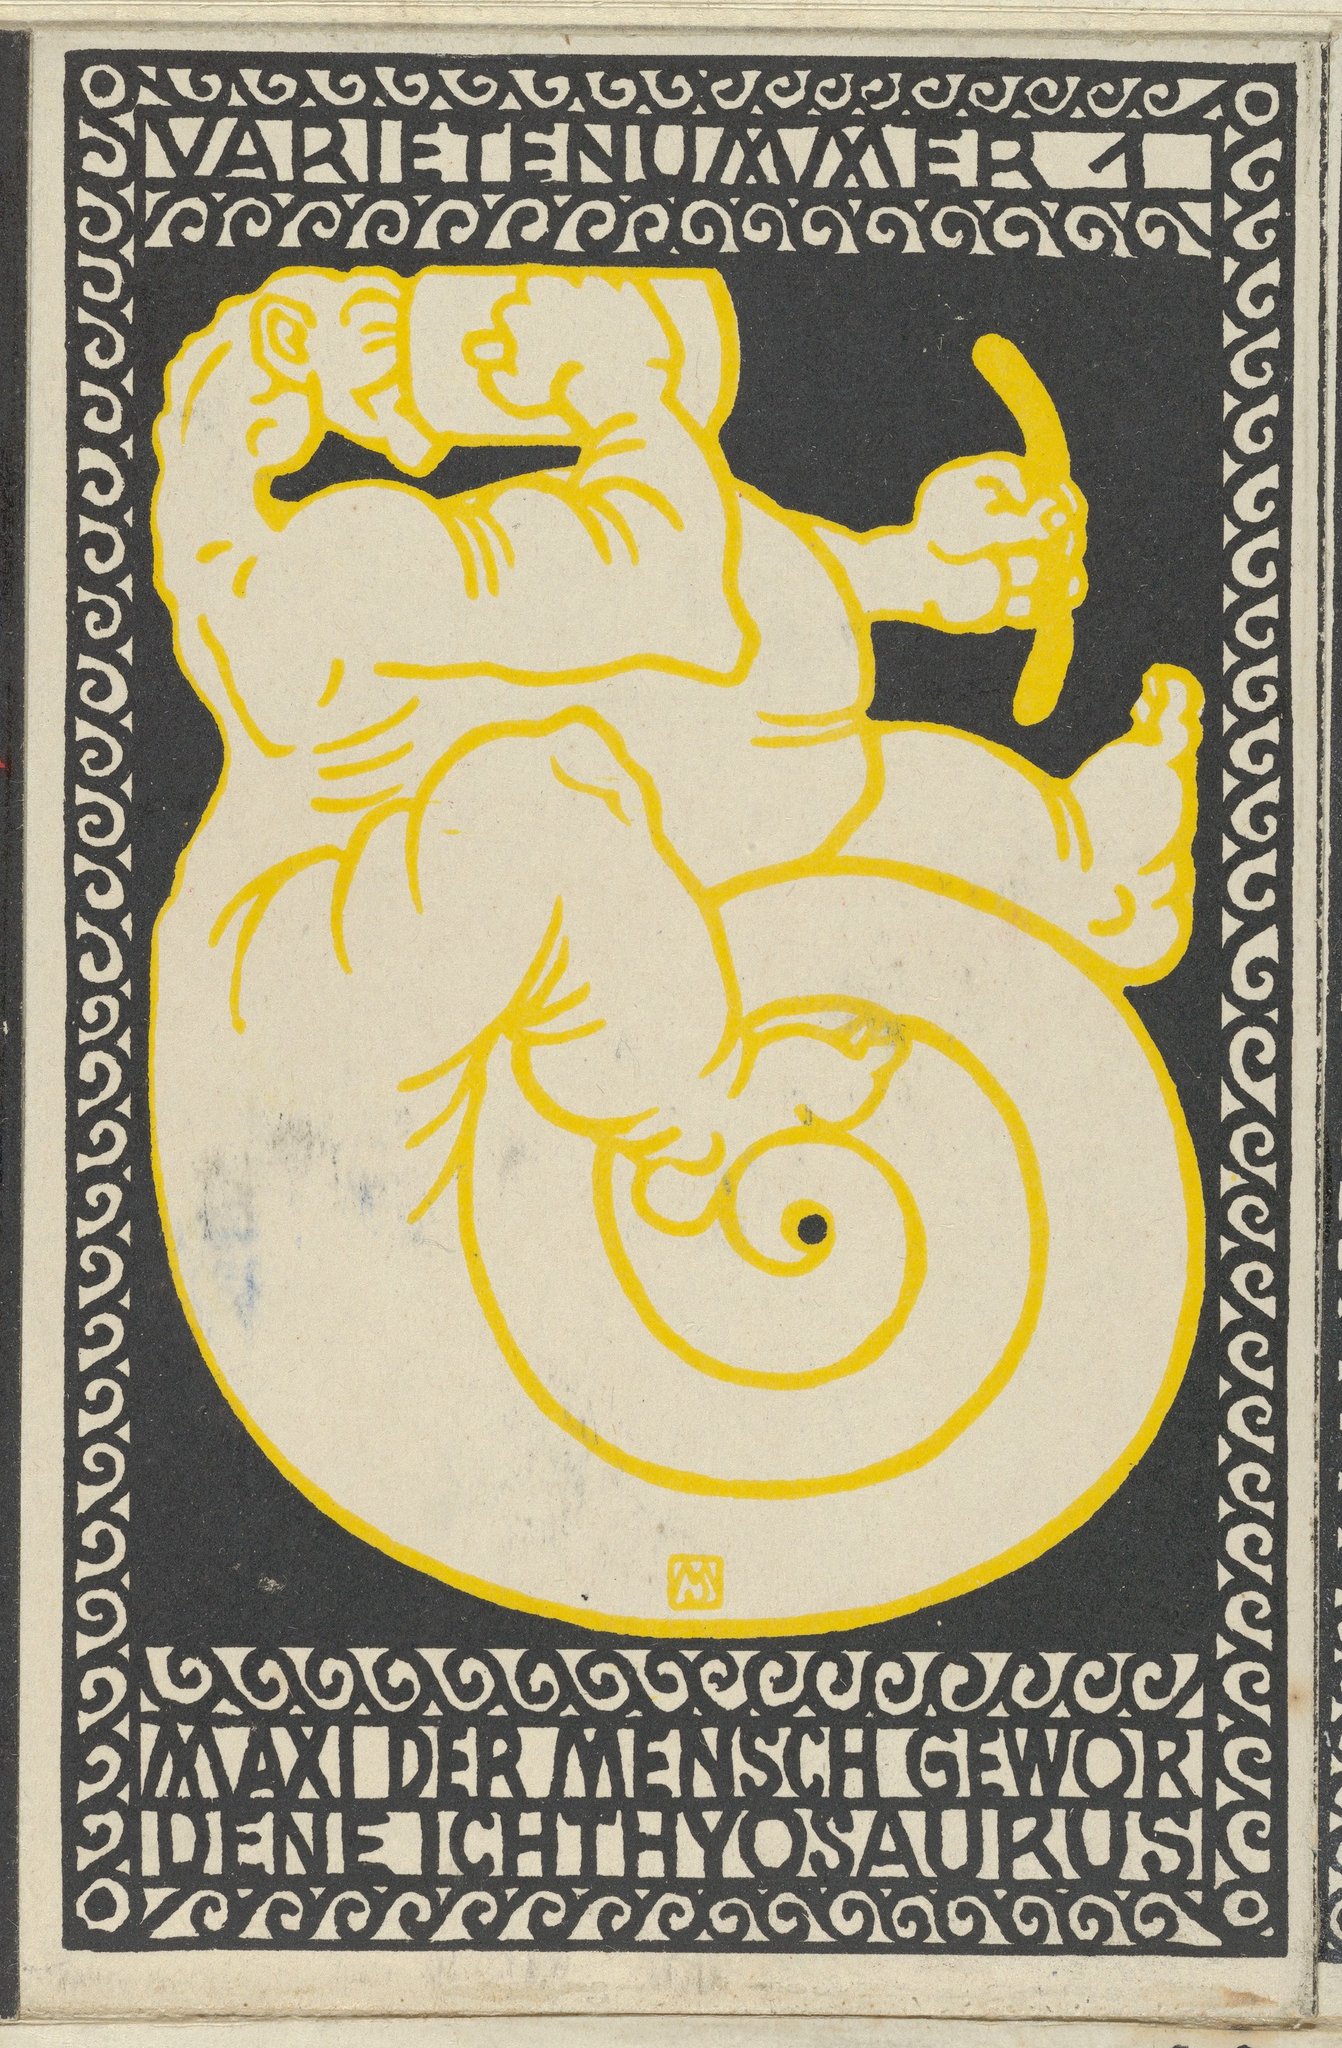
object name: print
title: Variety Act 1: Maxi the Ichthyosaurus Turned Man (Varietenummer 1: Maxi der Mensch Gewor Dene Ichthyosaurus)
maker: moriz jung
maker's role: artist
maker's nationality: austrian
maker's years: 1885-1915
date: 1907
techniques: lithograph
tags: mythical creatures,drinking